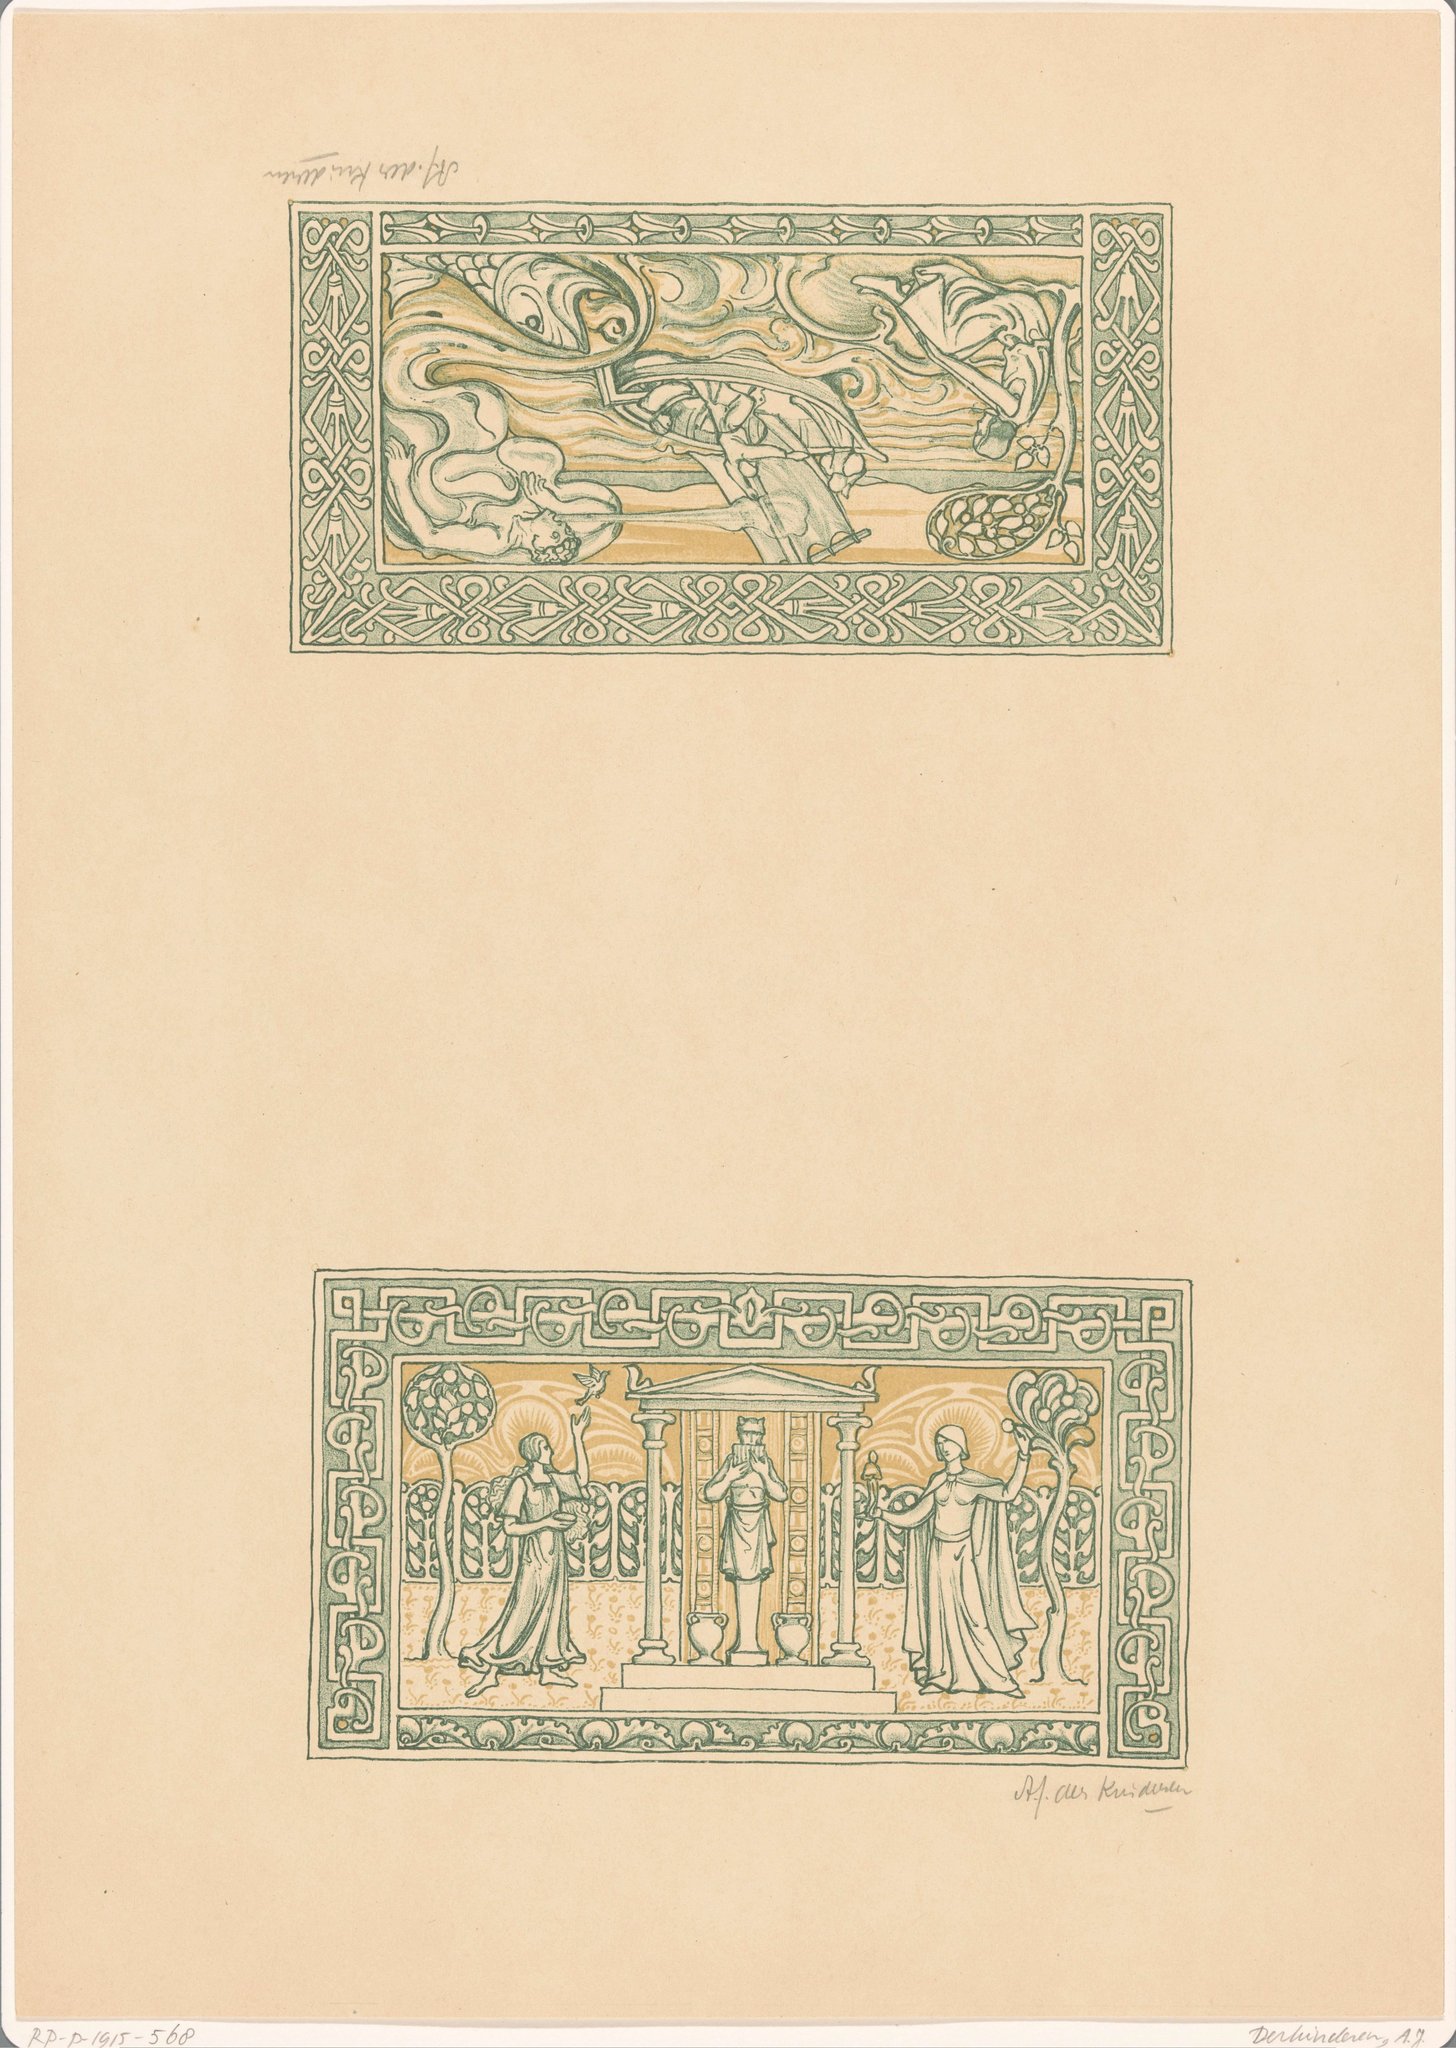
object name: book illustration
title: Twee voorstellingen met menselijke figuren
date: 1896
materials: paper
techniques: lithograph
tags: wind as a human face, blowing with rounded cheeks, panpipes, piece of sculpture, reproduction of a piece of sculpture, jonah in the fish's belly (jonah 2:1 - 3:2)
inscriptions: collector's mark: Lugt 2233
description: Boven twee figuren naast een tempel met daarin een beeld van een figuur die een panfluit bespeelt. Onder Jona, zittend op een eiland, kijkend naar de grote vis die hem had opgeslokt. Op het water een boot die door een personificatie van de wind wordt geteisterd.